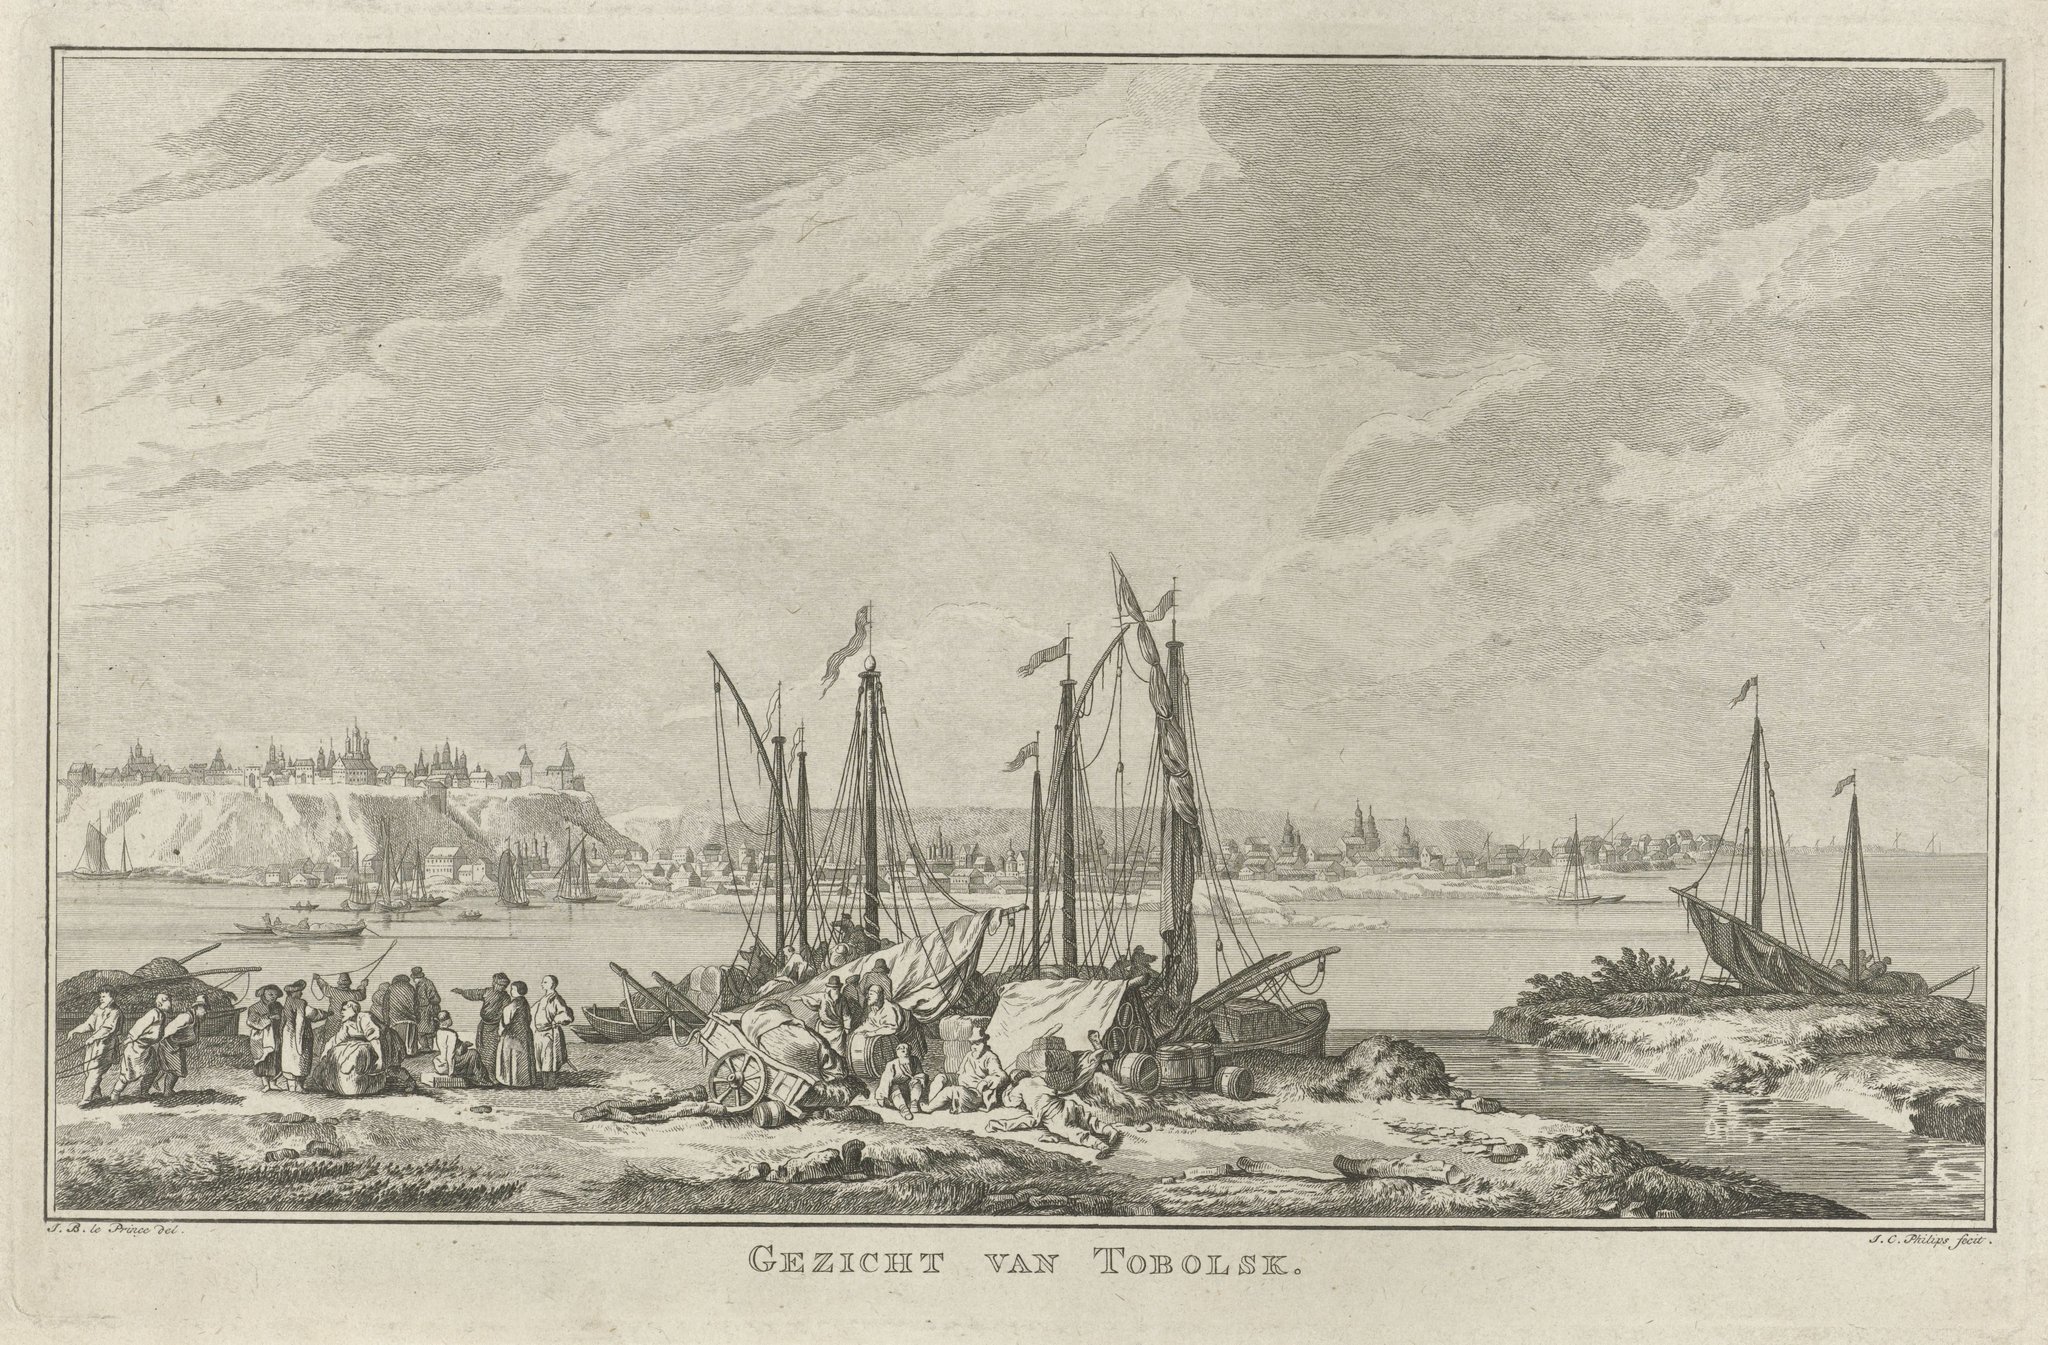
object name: print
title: Gezicht op Tobolsk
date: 1771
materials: paper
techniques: etching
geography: amsterdam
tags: landscapes in polar regions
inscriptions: collector's mark: Lugt 2228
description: Prent ook gebruikt als illustratie in: Chappe d'Auteroche, Jean. [Vertaald uit het Frans] Reize naar Siberië, op bevel des konings van Vrankryk ondernomen in 1761. Deventer: Lucas Leemhorst, 1771.